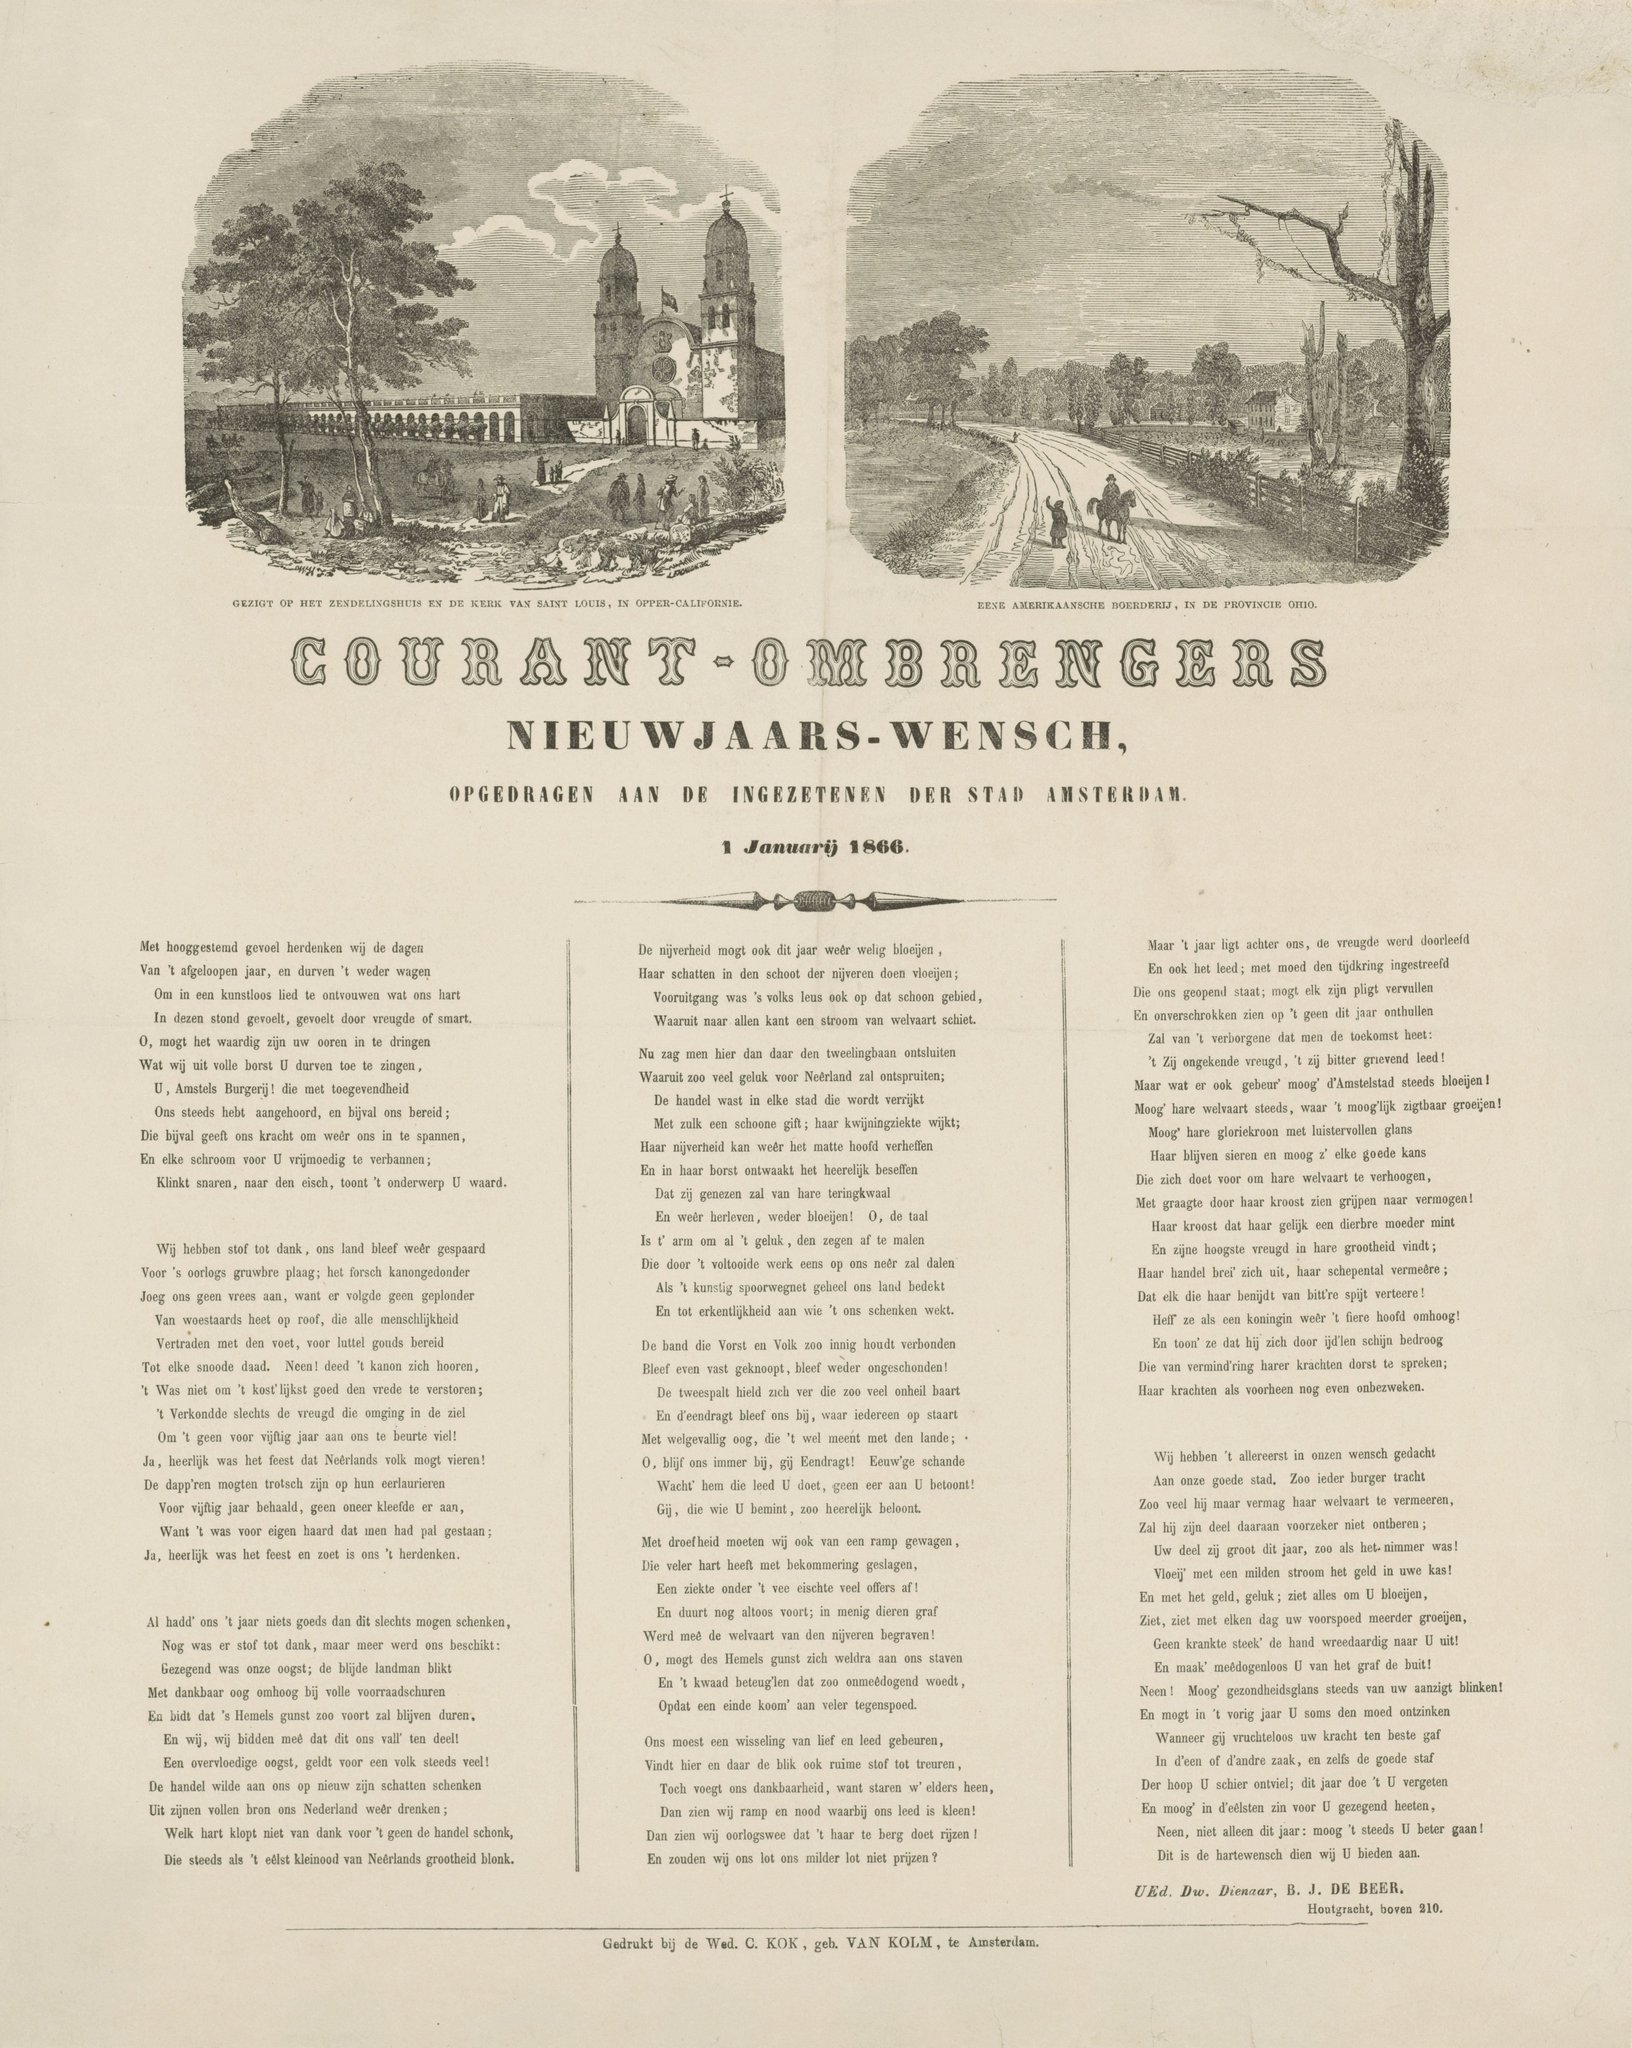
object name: print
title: Courant-ombrengers Nieuwjaars-Wensch (...) 1866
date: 1865-1866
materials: paper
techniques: letterpress printing, engraving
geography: amsterdam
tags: church (exterior)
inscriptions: collector's mark: Lugt 2228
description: Nieuwjaarswens namens de ombrengers van couranten (krantenbezorgers) te Amsterdam voor het jaar 1866. Bovenaan twee scènes uit de Verenigde Staten, met links de kerk Mission San Luis Rey de Francia in Californië, rechts een boerderij in Ohio. Onderaan een gedicht in drie kolommen. Van de courantombrenger: B.J. de Beer.